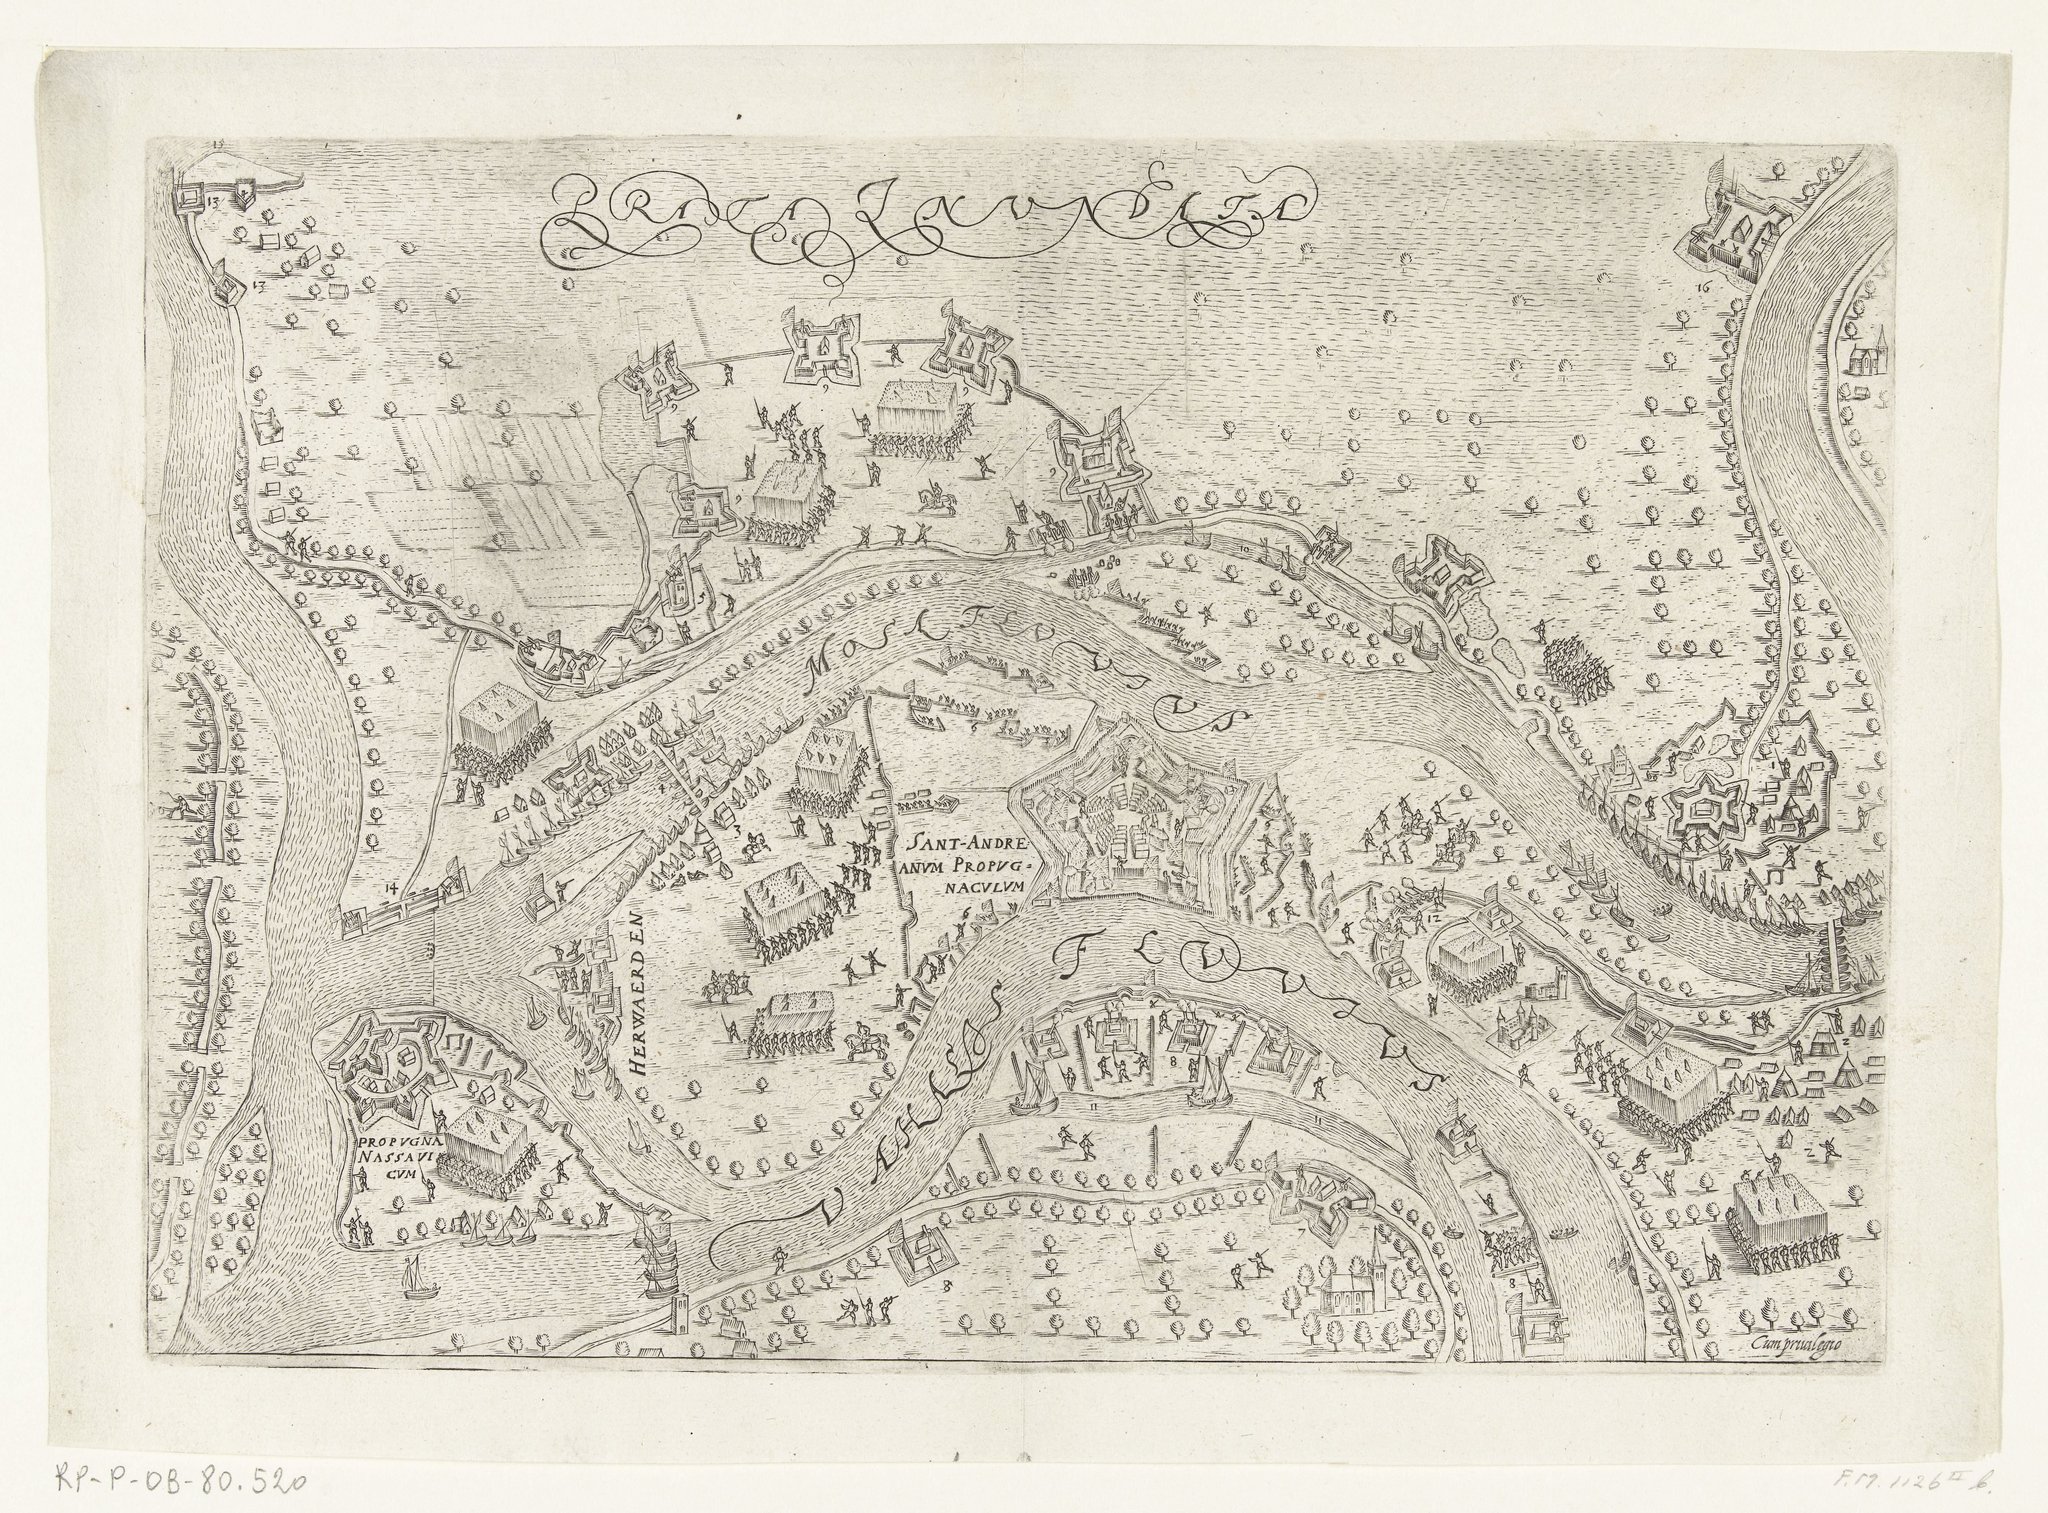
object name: print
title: Beleg en inname van Sint-Andries door Maurits, 1600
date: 1600-1601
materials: paper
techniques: engraving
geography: northern netherlands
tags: delft, frederick henry (prince of orange), maurice (prince of orange), capture of city (after the siege)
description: Gebruikt als illustratie in: J.J. Orlers, Den Nassauschen Lauren-Crans: Beschrijvinghe ende af-beeldinge van alle de victorien ... die Godt Almachtich de ... Staten der Vereenichde Nederlanden verleent heeft, deur het wijs ende clouck beleyt des Hooch-ghebooren Fursts Maurits van Nassau, J.J. Orlers en H. van Haestens, Leiden 1610, fol. 144/145.